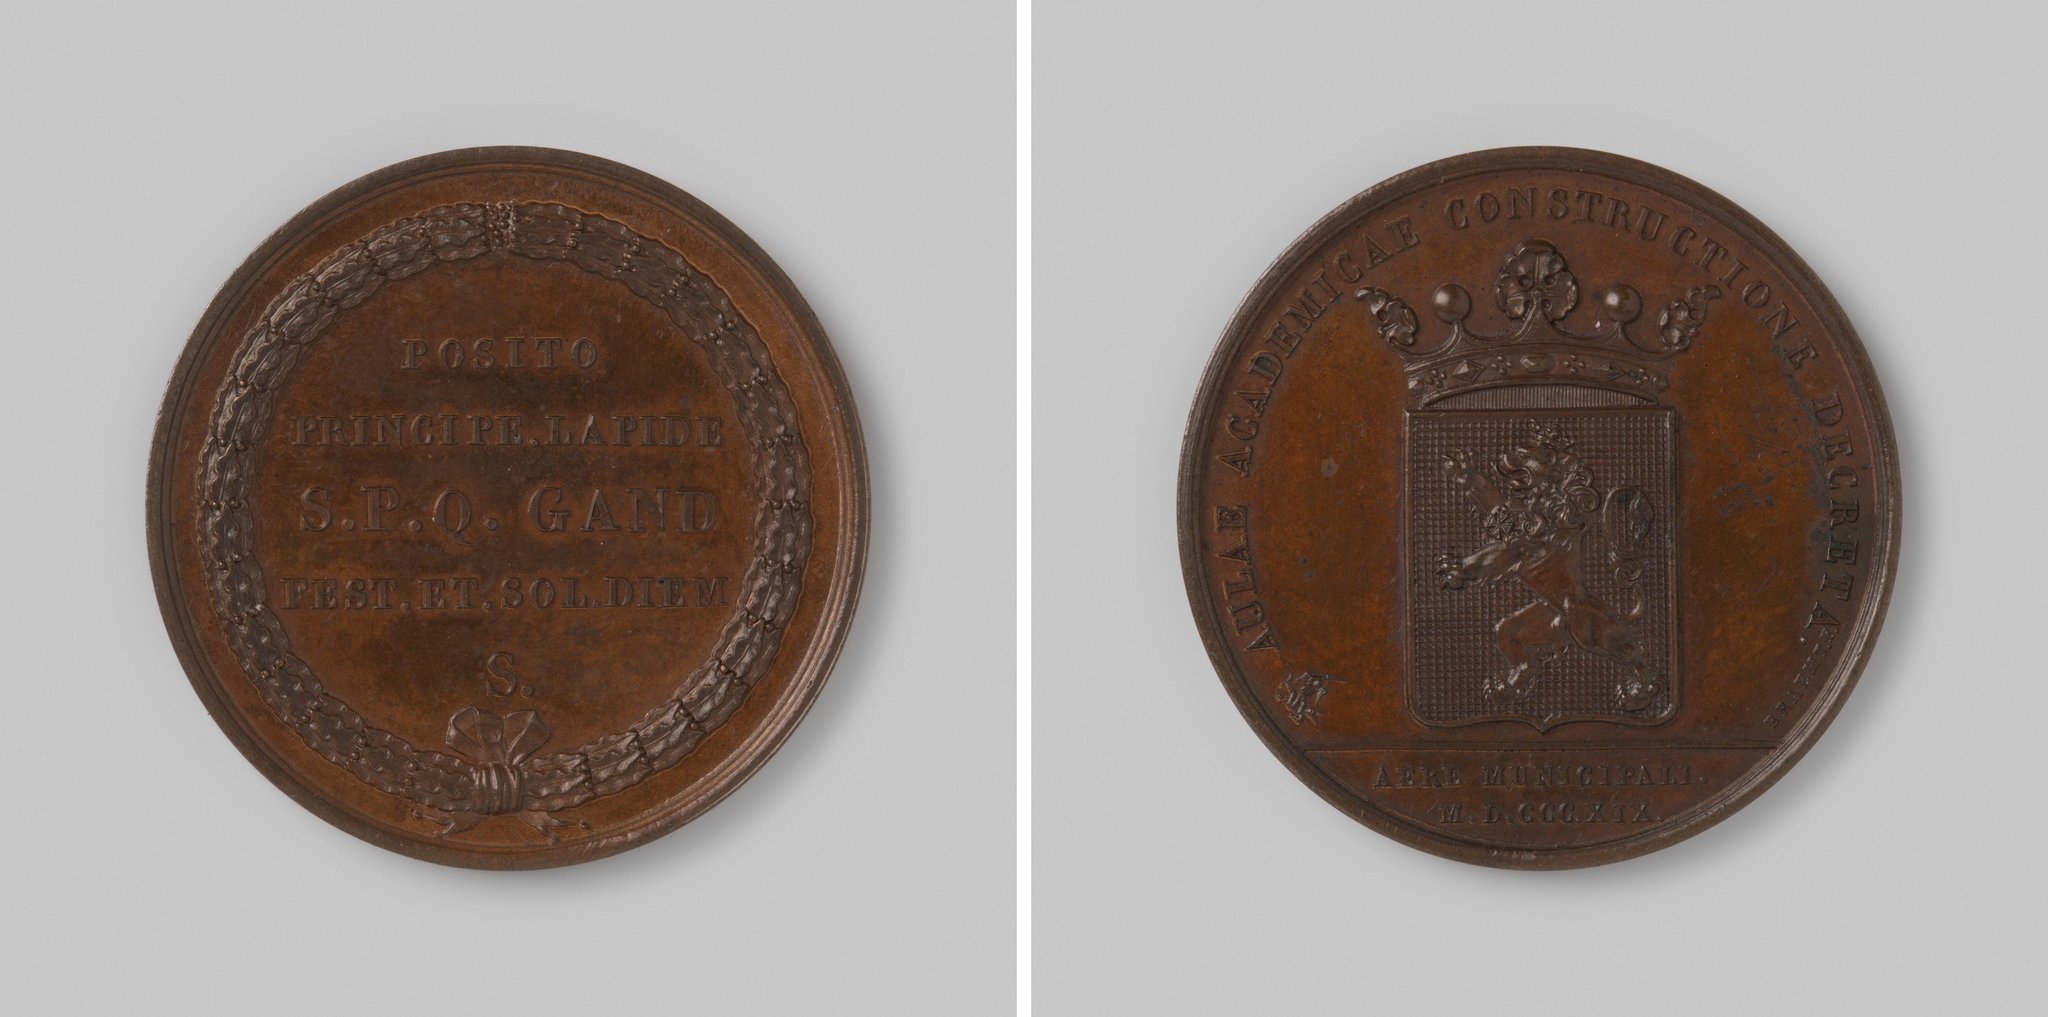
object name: history medal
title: Eerstesteenlegging van het Akademiegebouw te Gent 1819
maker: joseph pierre braemt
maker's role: print maker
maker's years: 1796-1864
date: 1819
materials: bronze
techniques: striking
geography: brussels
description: Bronzen penning, op de voorzijde vier regels tekst binnen een lauwerkrans, op de keerzijde het gekroonde wapenschild van Vlaanderen met omschrift en afsnedetekst.